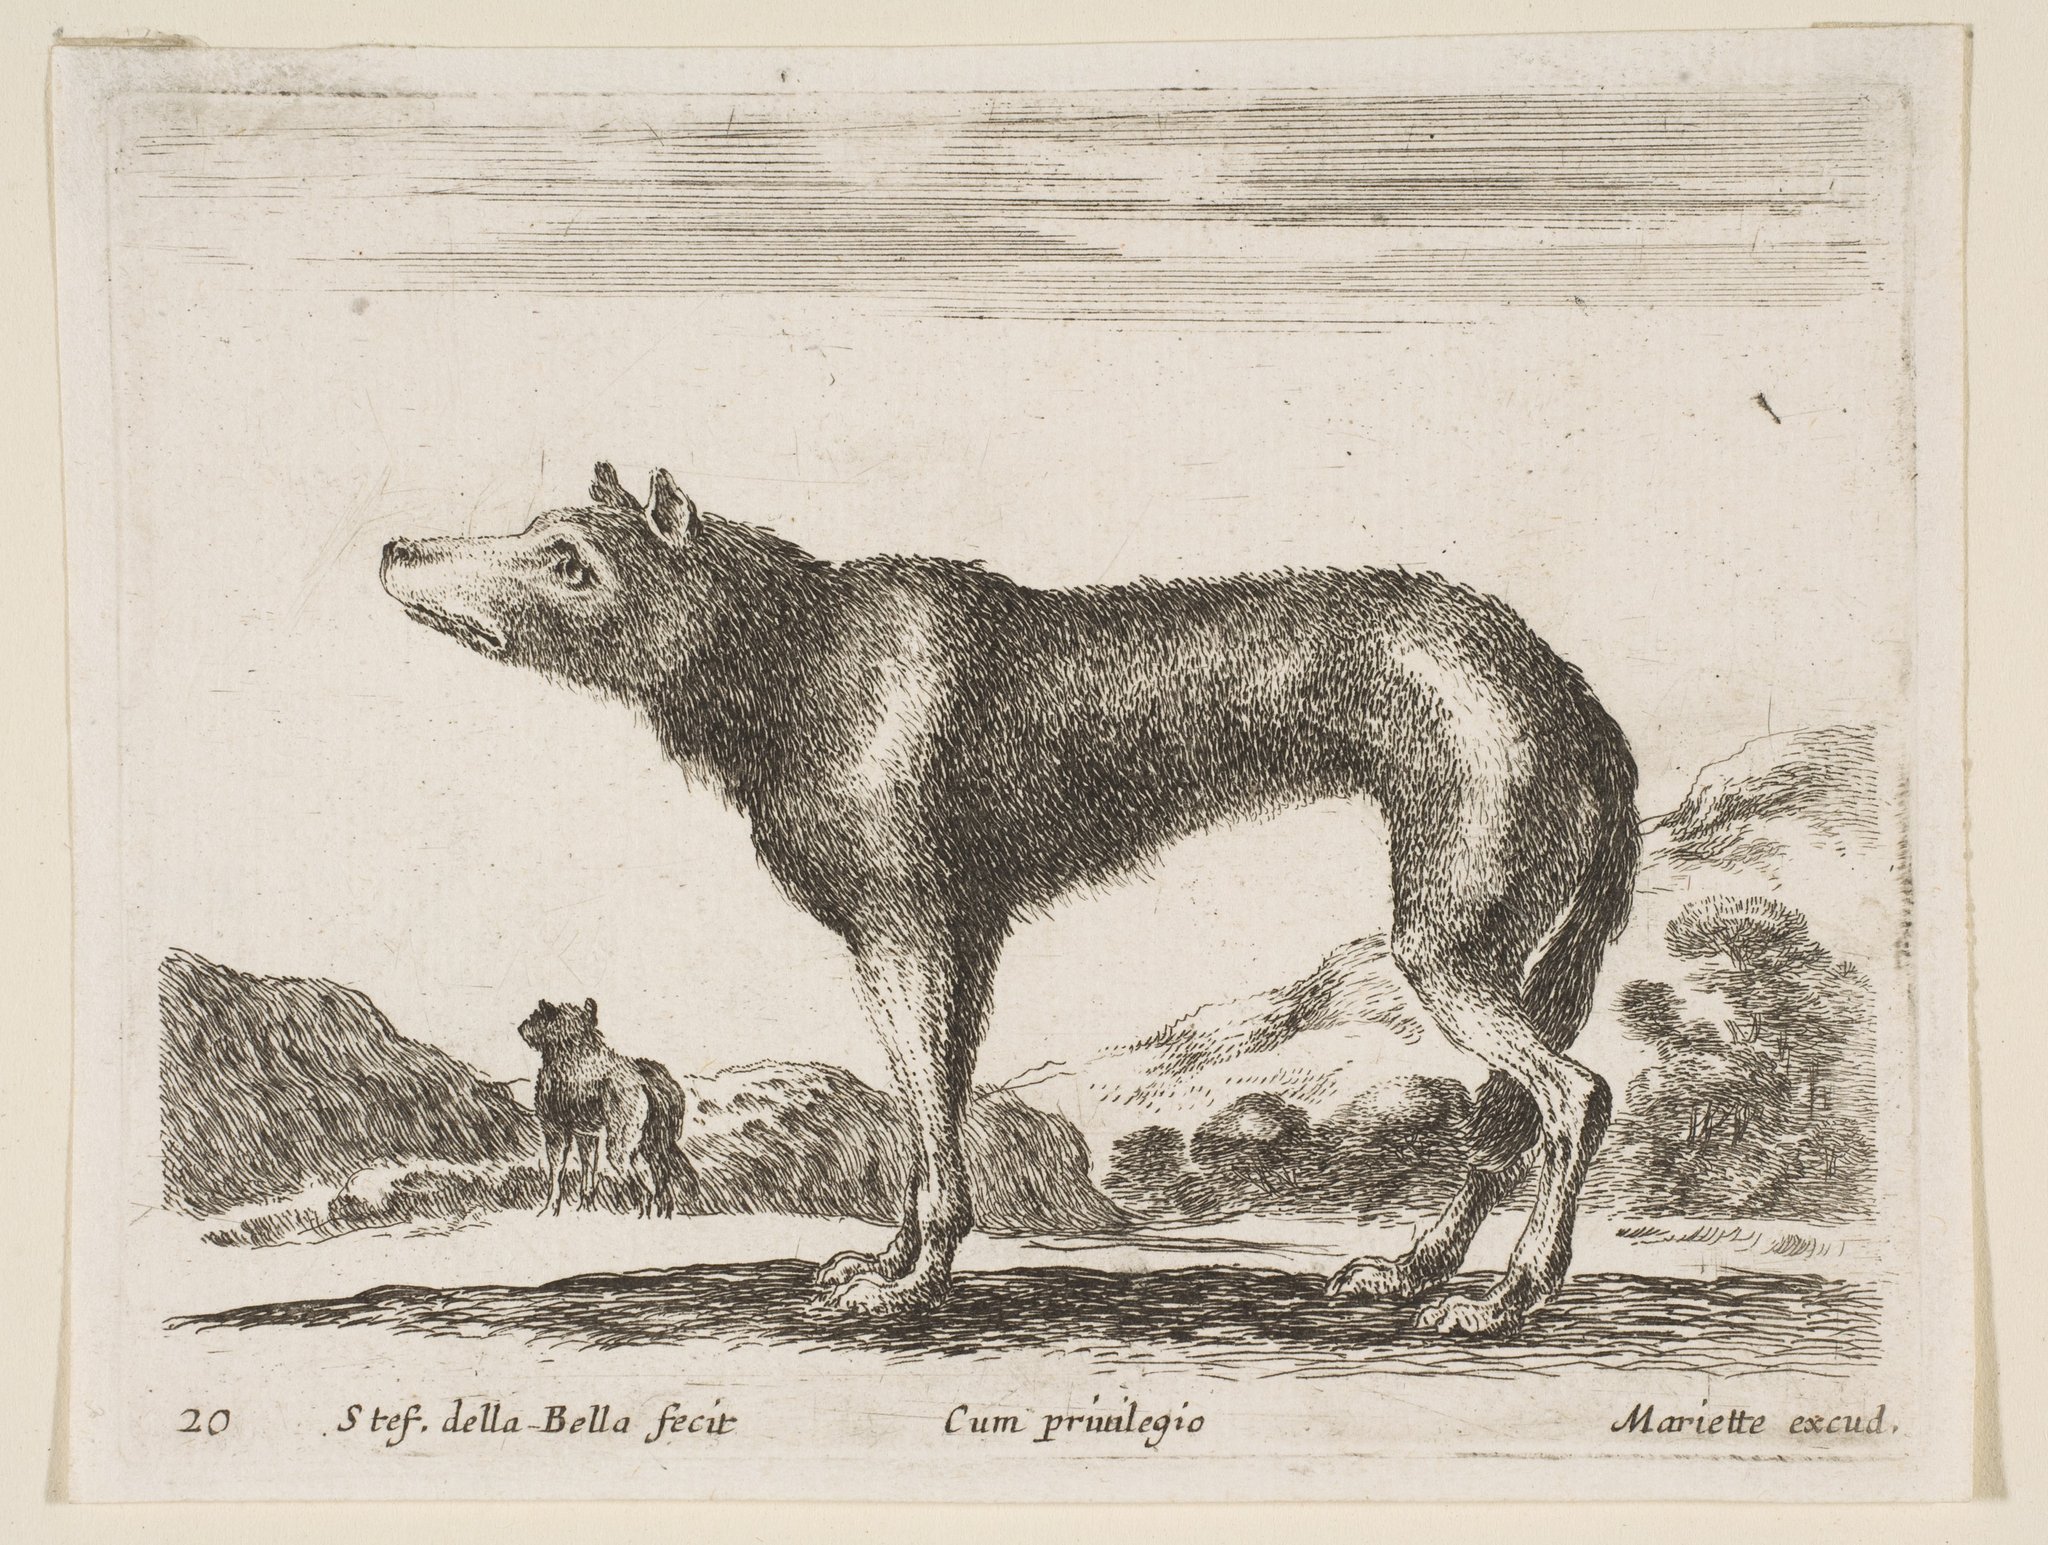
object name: print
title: Wolf, plate 20 from "Various Animals" (Diversi Animali)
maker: stefano della bella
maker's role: artist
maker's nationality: italian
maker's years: 1610-1664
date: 1641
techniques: etching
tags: wolves